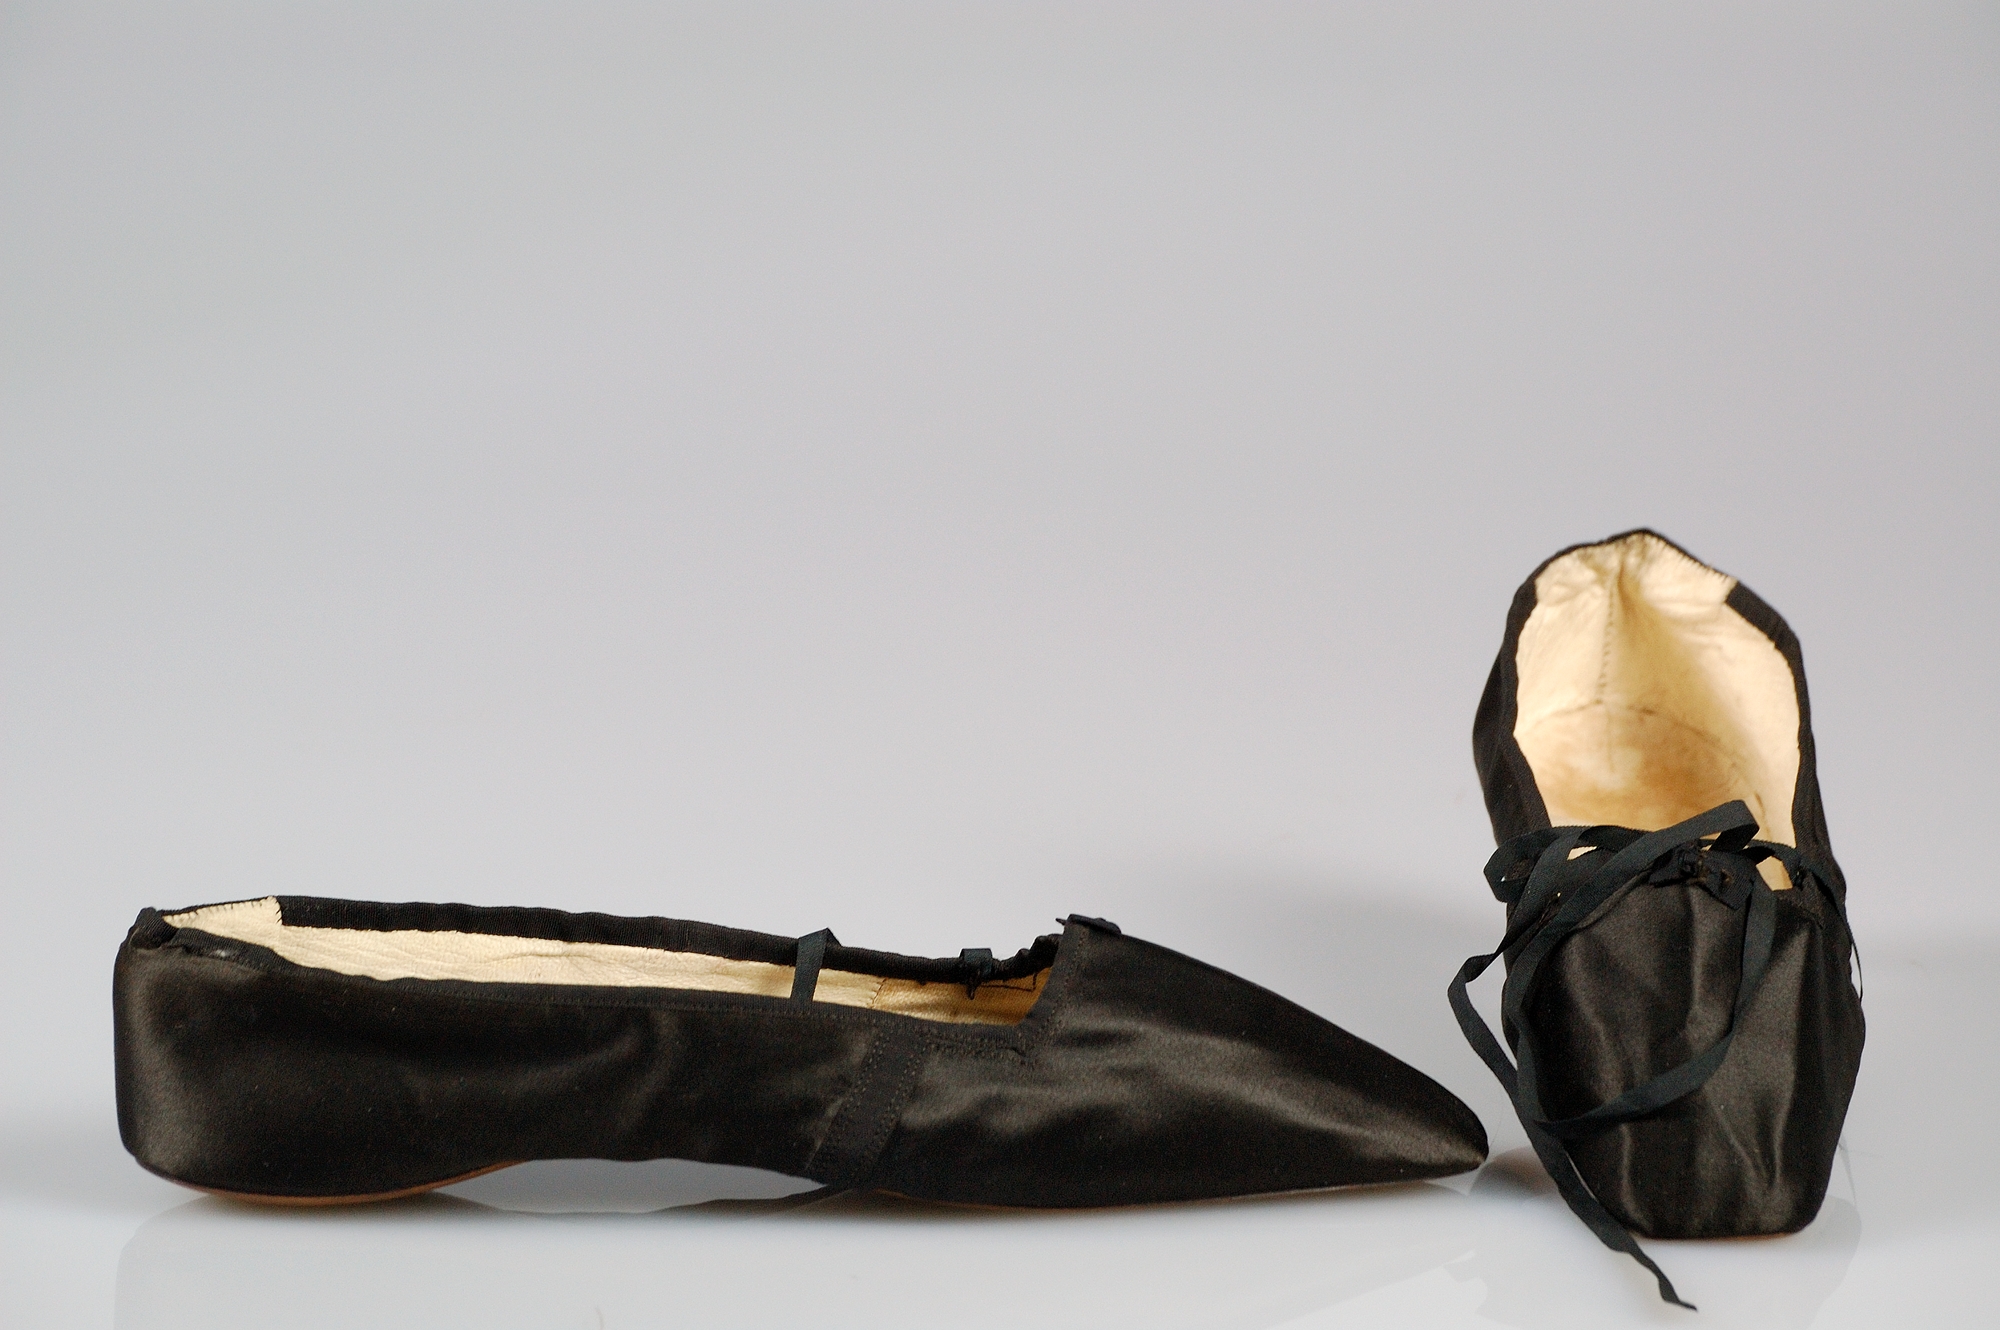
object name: evening slipper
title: Evening slippers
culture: british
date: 1855-1865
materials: silk